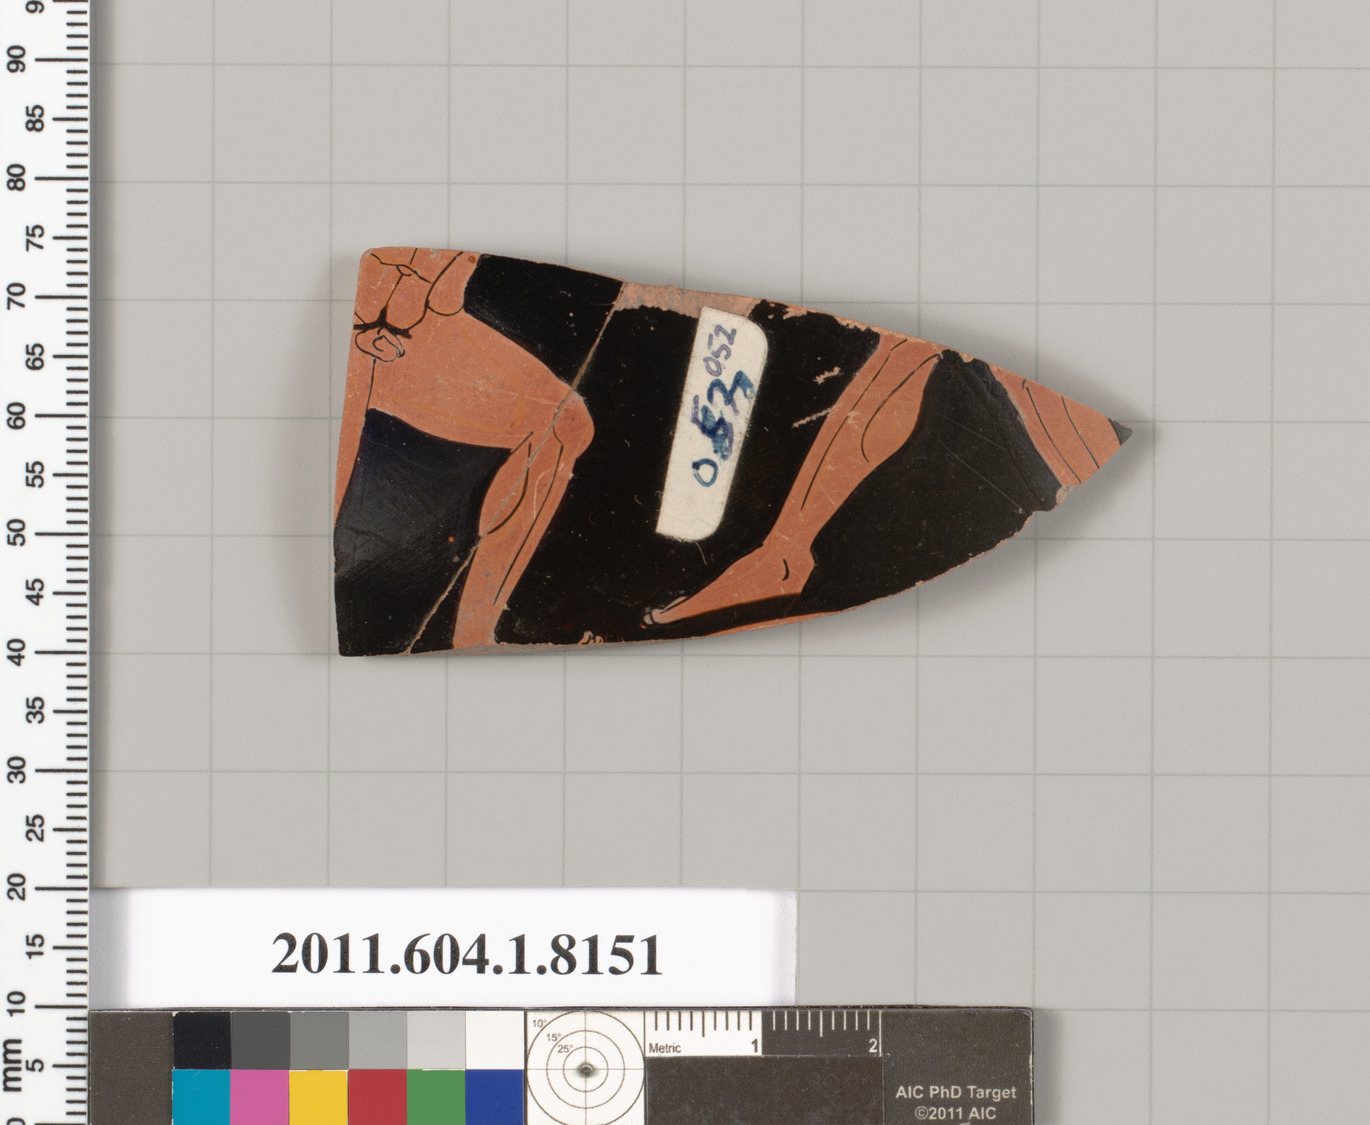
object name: kylix fragment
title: Terracotta fragment of a kylix (drinking cup)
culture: greek, attic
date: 510-490 BCE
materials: terracotta